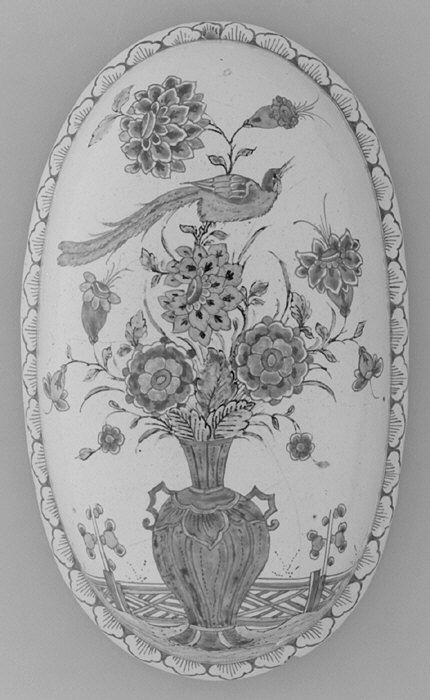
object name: brush back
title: Pair of brush backs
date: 1701-1800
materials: faience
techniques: glazing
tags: birds,flowers